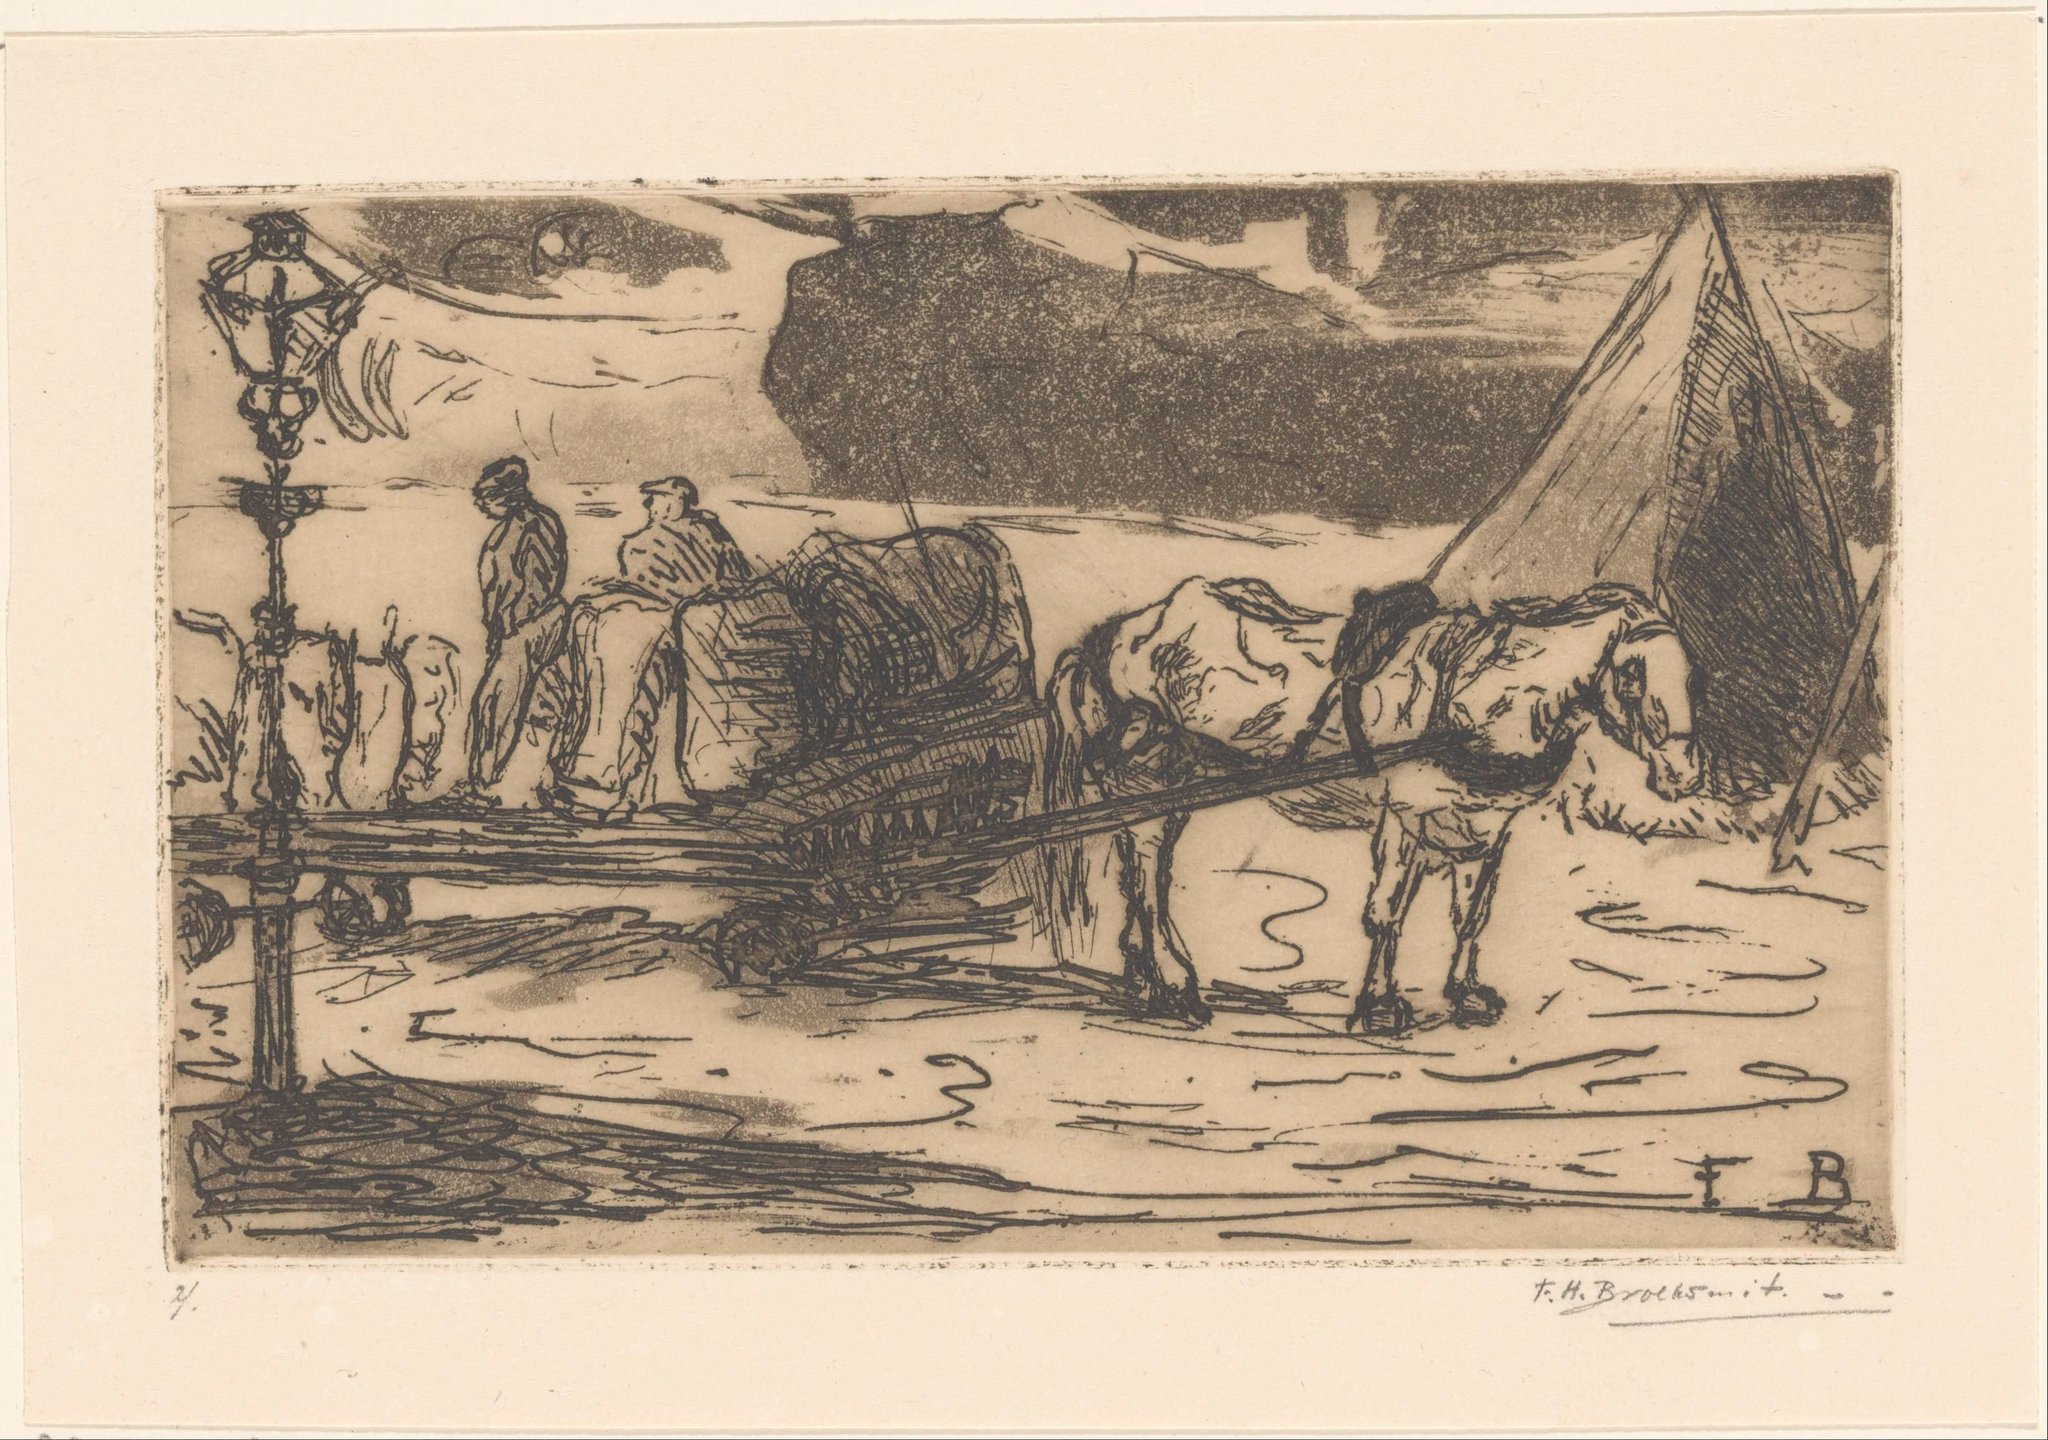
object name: print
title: Winterse havenkade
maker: frederika henriëtte broeksmit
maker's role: draughtsman, print maker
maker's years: 1875-1945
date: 1885-1931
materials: paper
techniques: aquatint, etching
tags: four-wheeled, animal-drawn vehicle, e.g.: cab, carriage, coach, snow, horse, pier, quay, wharf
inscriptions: collector's mark: Lugt 2228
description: Een paard gespannen voor een wagen met vracht op een met sneeuw bedekte kade. Links een lantaarnpaal, op de achtergrond het silhouet van een schip.